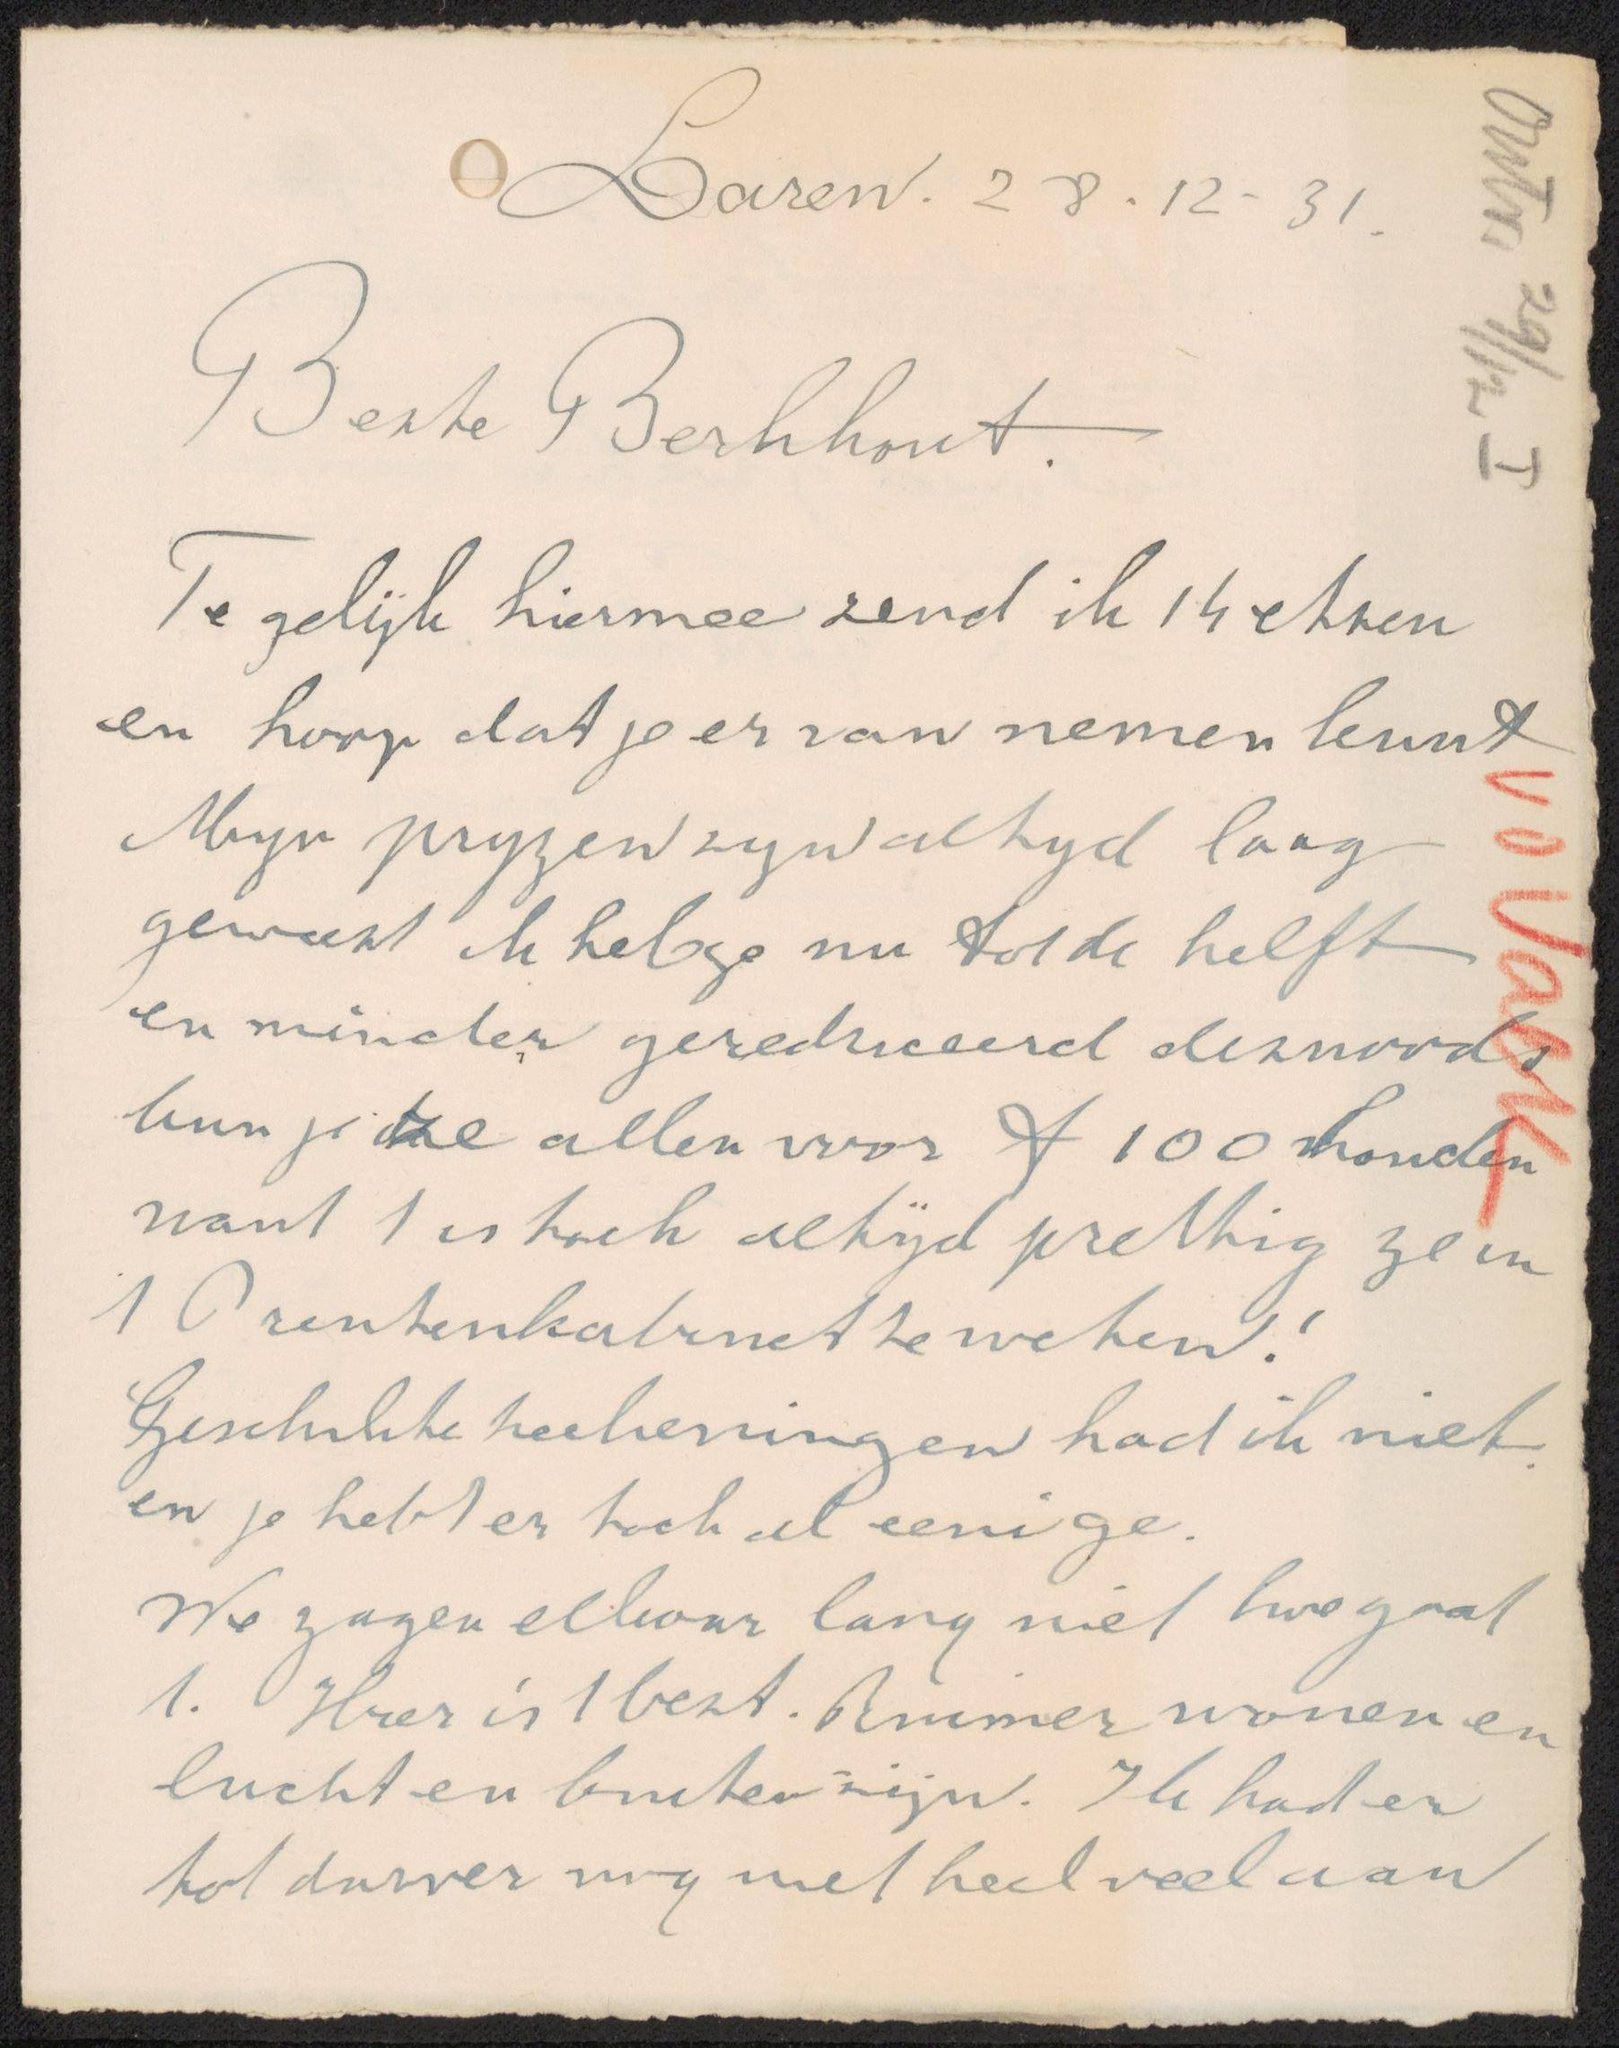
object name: letter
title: Brief aan jonkheer Hendrik Teding van Berkhout (1879-1969)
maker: maurits van der valk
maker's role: draughtsman, print maker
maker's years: 1857-1935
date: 1931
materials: ink, paper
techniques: pen, writing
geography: laren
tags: print room, amsterdam, jonkheer hendrik teding van berkhout (1879-1969), the graphic arts, art collecting, money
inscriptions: watermark